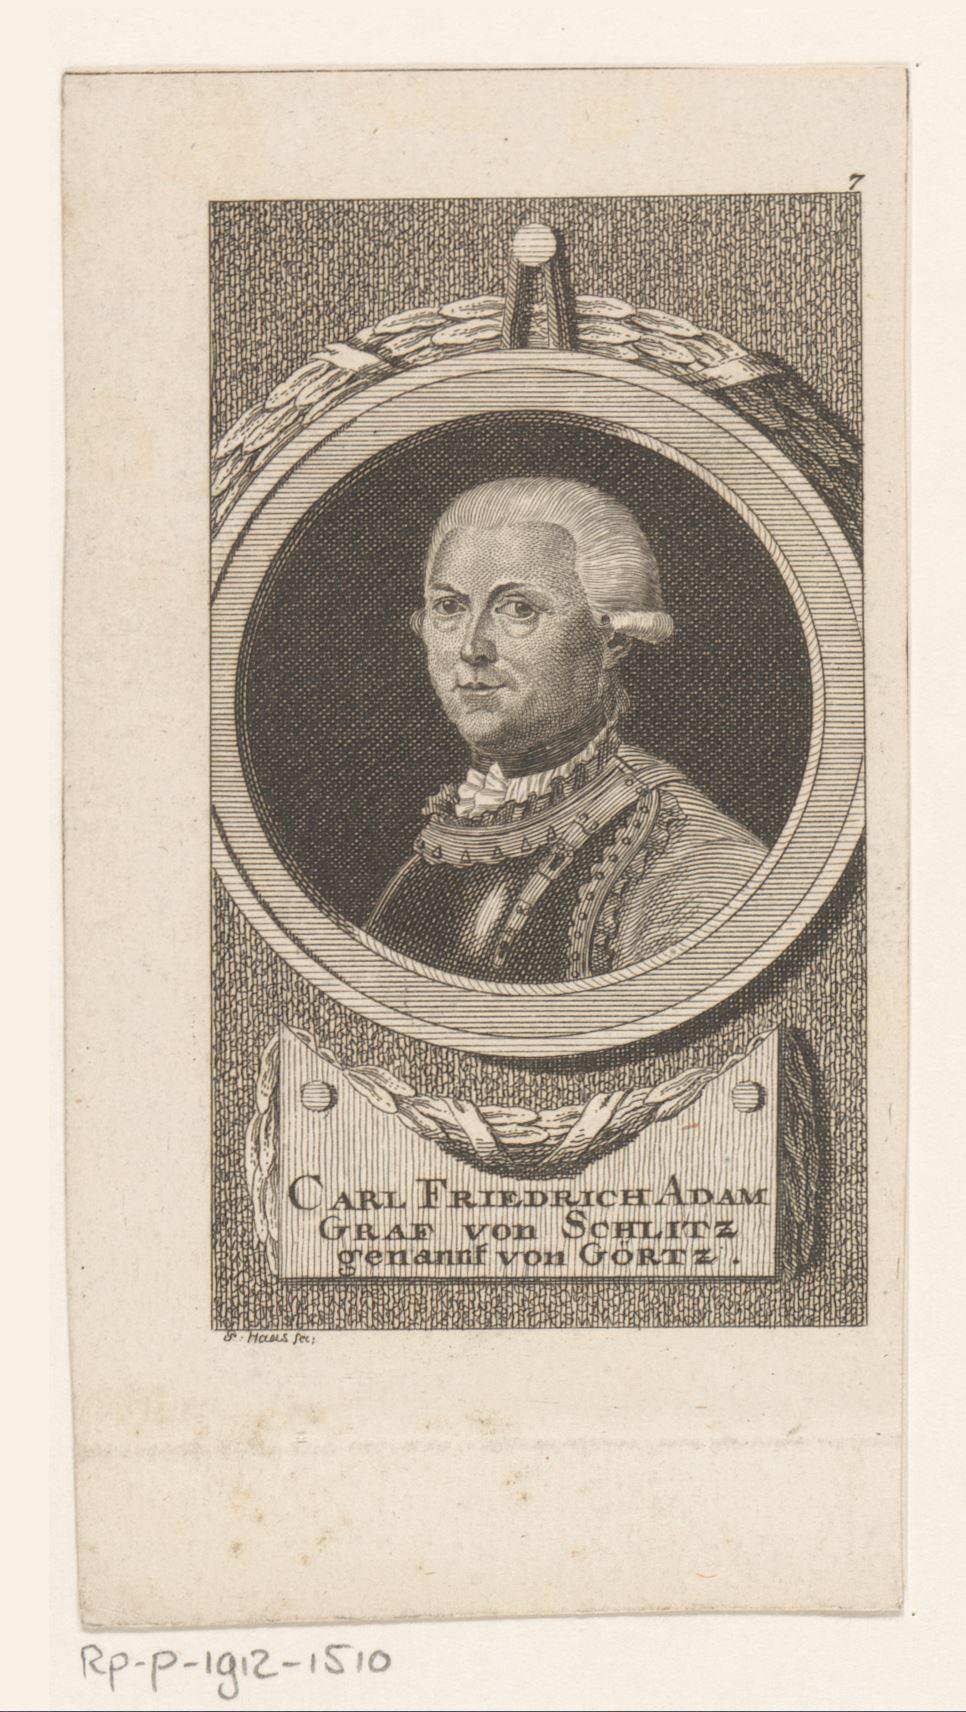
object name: print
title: Portret van Karl Friedrich Adam Graf von Görtz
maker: peter haas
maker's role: print maker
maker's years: 1754-1804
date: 1764-1804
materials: paper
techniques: engraving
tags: ornament ~ medallion, armour, historical persons, ornament ~ festoon, garland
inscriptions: collector's mark: Lugt 2228